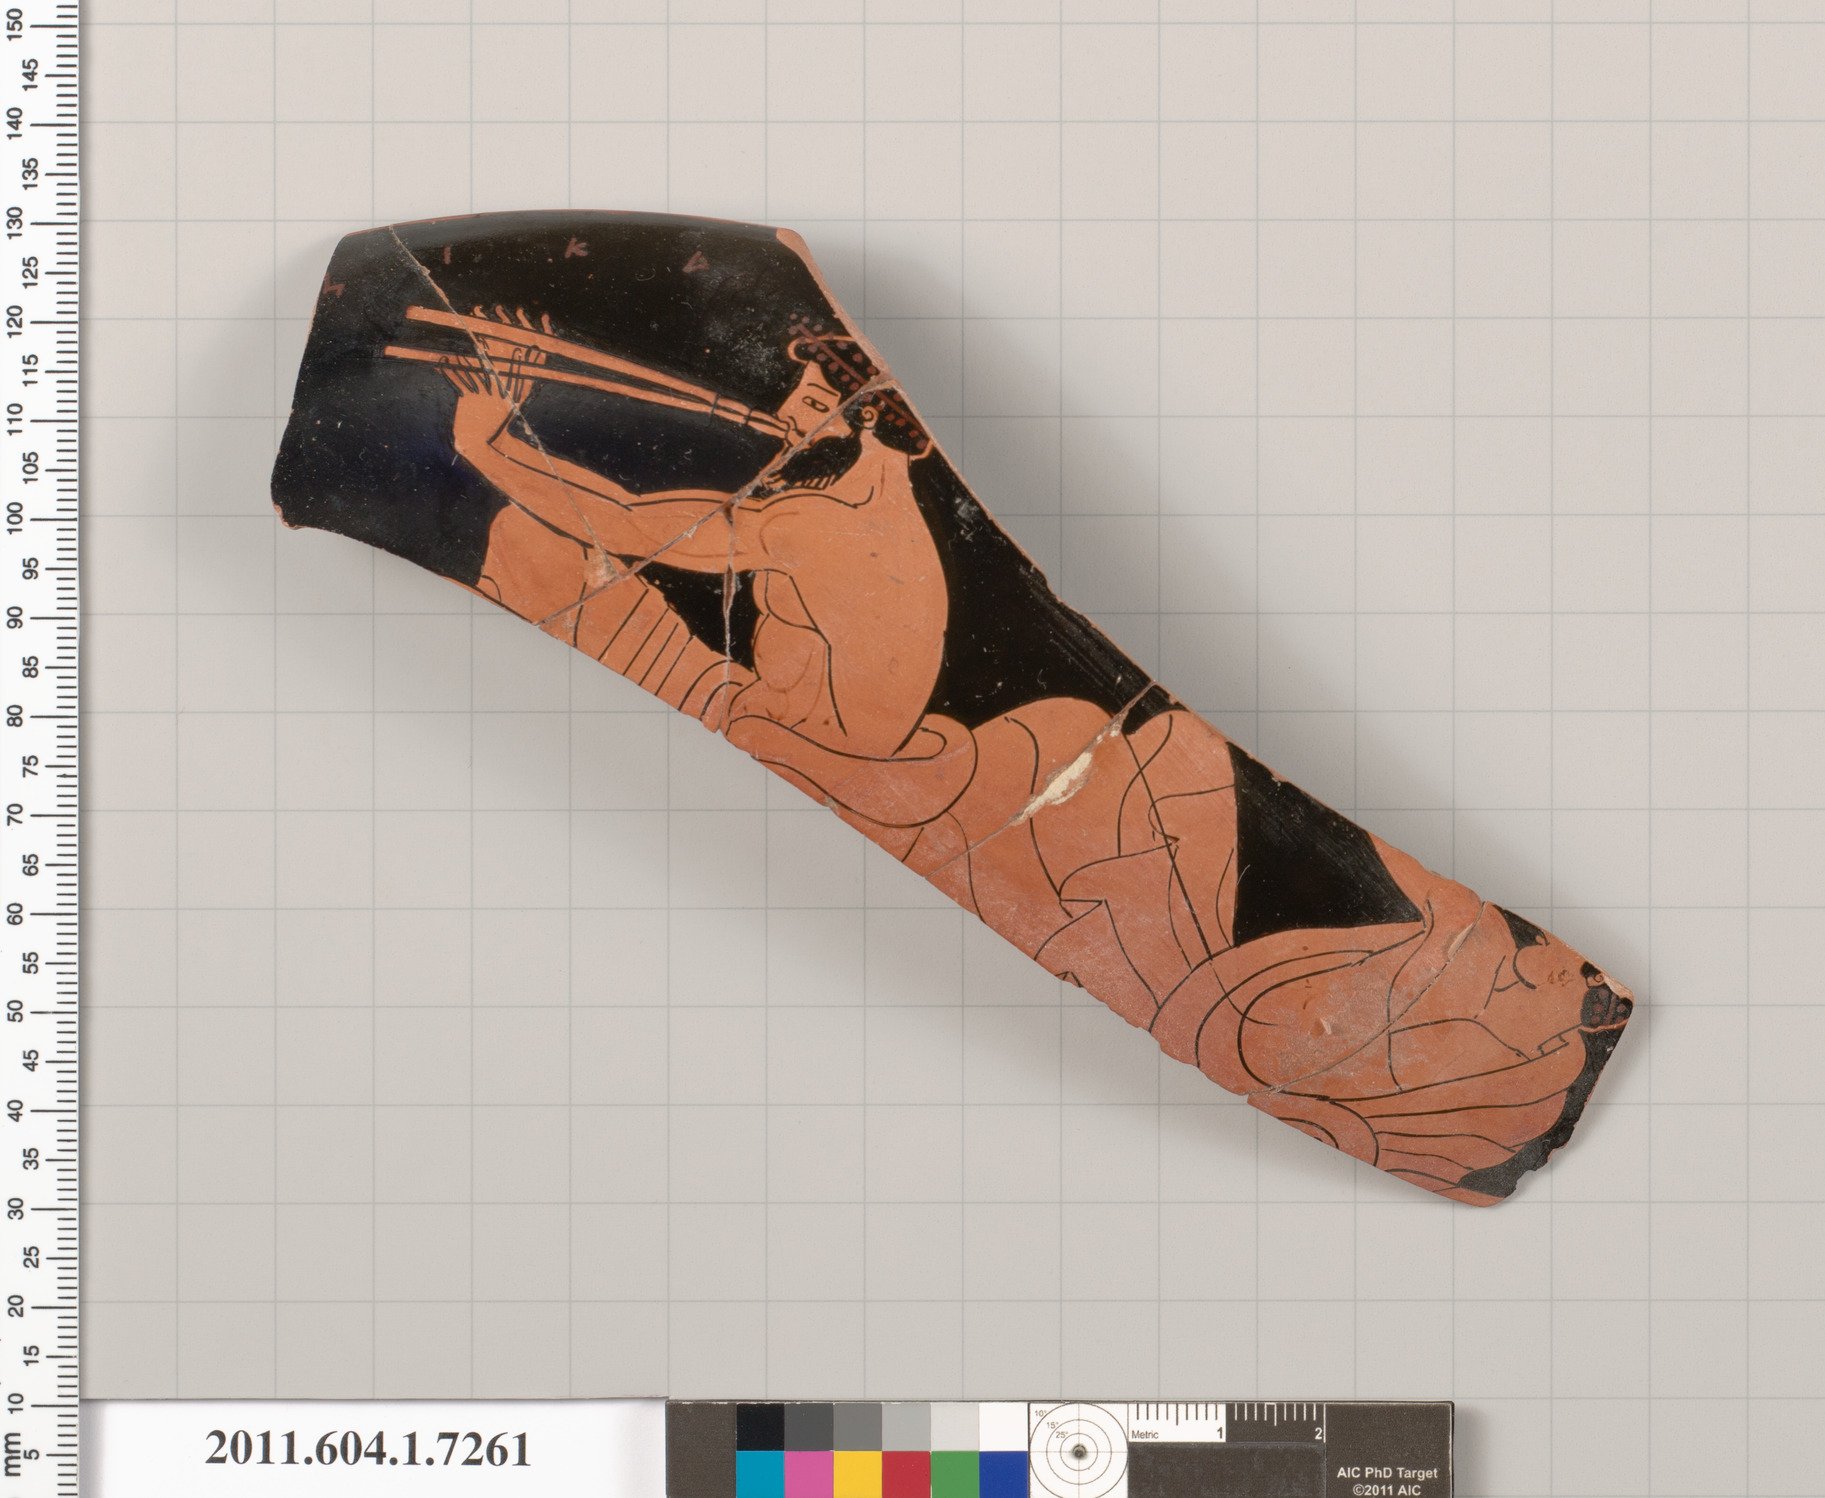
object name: kylix fragment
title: Terracotta rim fragment of a kylix (drinking cup)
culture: greek, attic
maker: makron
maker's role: artist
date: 500-480 BCE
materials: terracotta